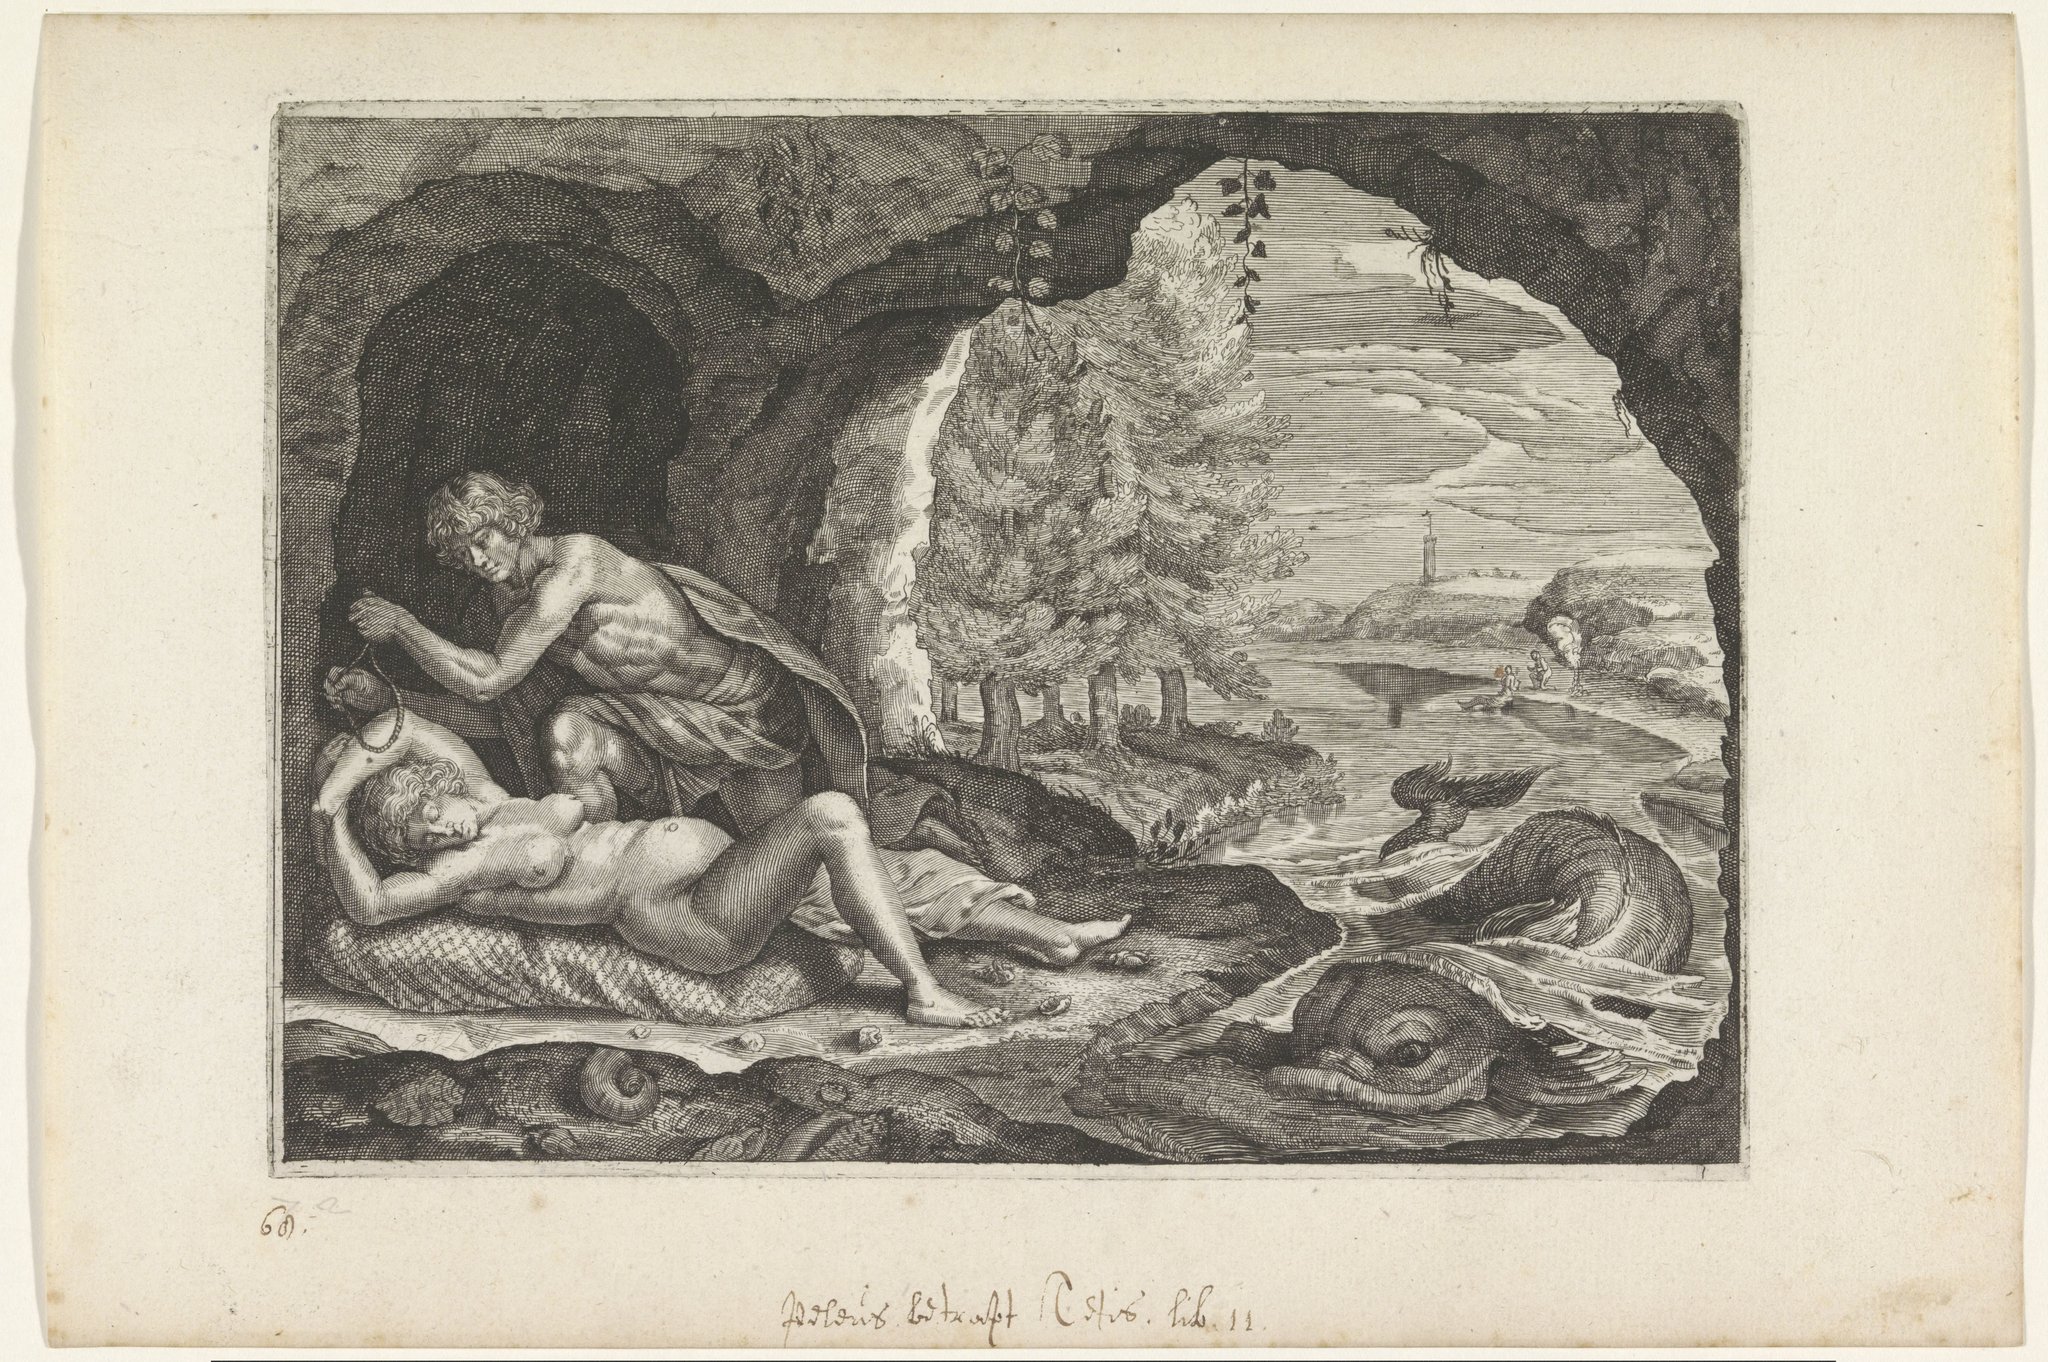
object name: print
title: Peleus besluipt de slapende Thetis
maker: crispijn van de passe (ii)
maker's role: draughtsman, print maker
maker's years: 1594-1670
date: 1636-1670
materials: paper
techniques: engraving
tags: thetis, asleep on the shore, is assailed by peleus; she tries to elude him by assuming different shapes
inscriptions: number: ‘68’, collector's mark: ‘Hinloopen’, annotation: ‘Peleus betrapt Tetis. lib. 11.’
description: Deze incomplete serie, bestaande uit 77 van de in totaal 85 prenten met scènes uit Ovidius' Metamorfosen, werd in 1709 samen met Ovidius-illustraties van Tempesta, Goltzius en Le Pautre in één album, Schijnvoet nummer 43, ingebonden. In de negentiende eeuw werd deze band weer uit elkaar gehaald.